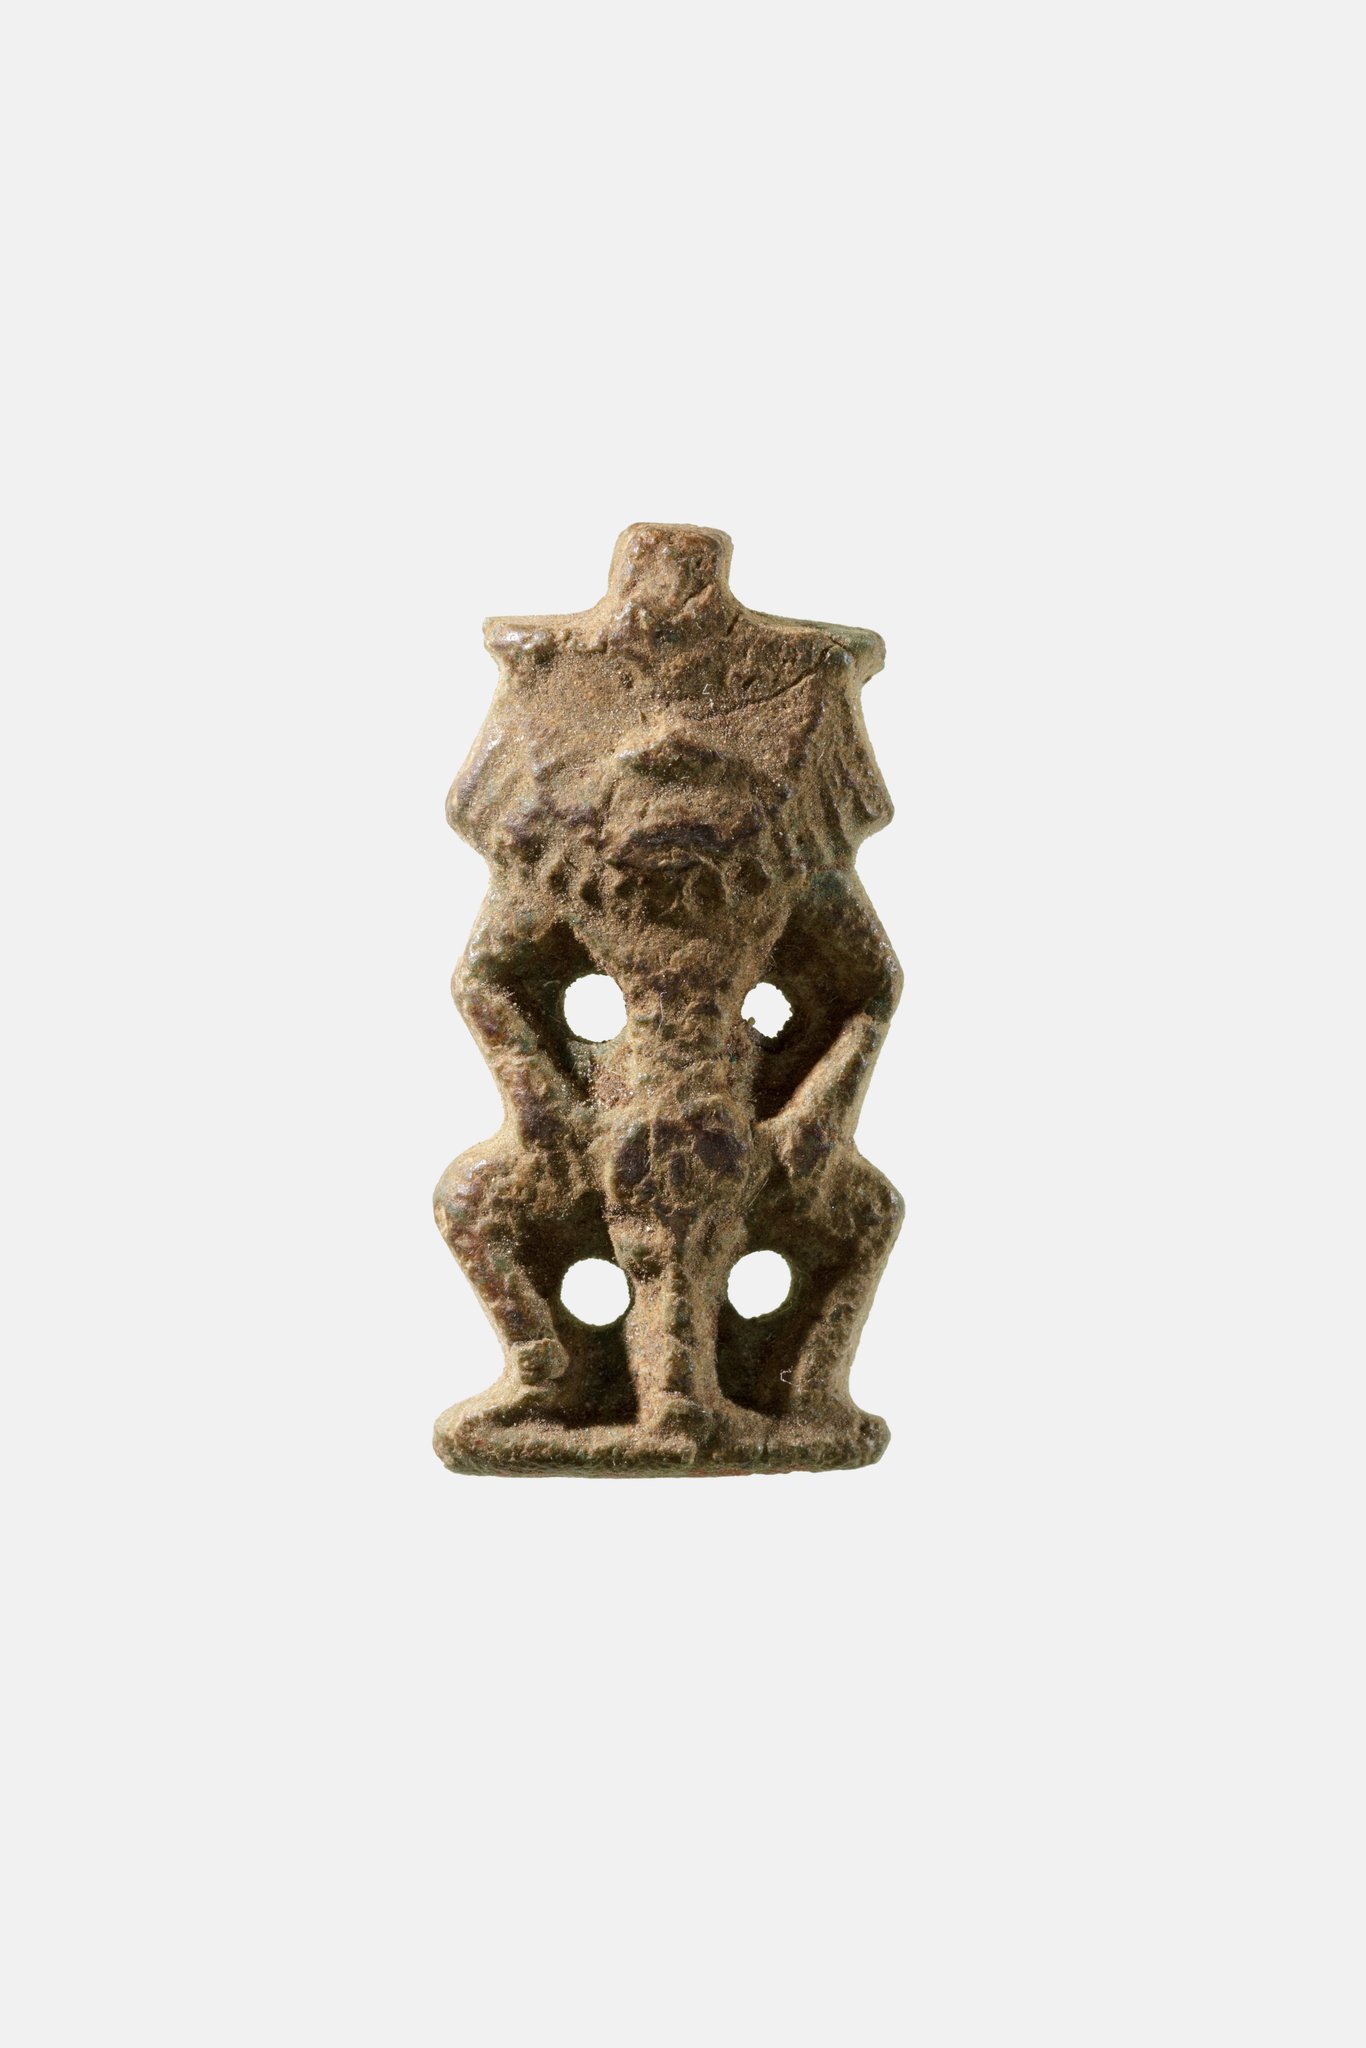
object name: amulet, be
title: Bes Amulet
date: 1550-1295 BCE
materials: faience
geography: northern upper egypt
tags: bes